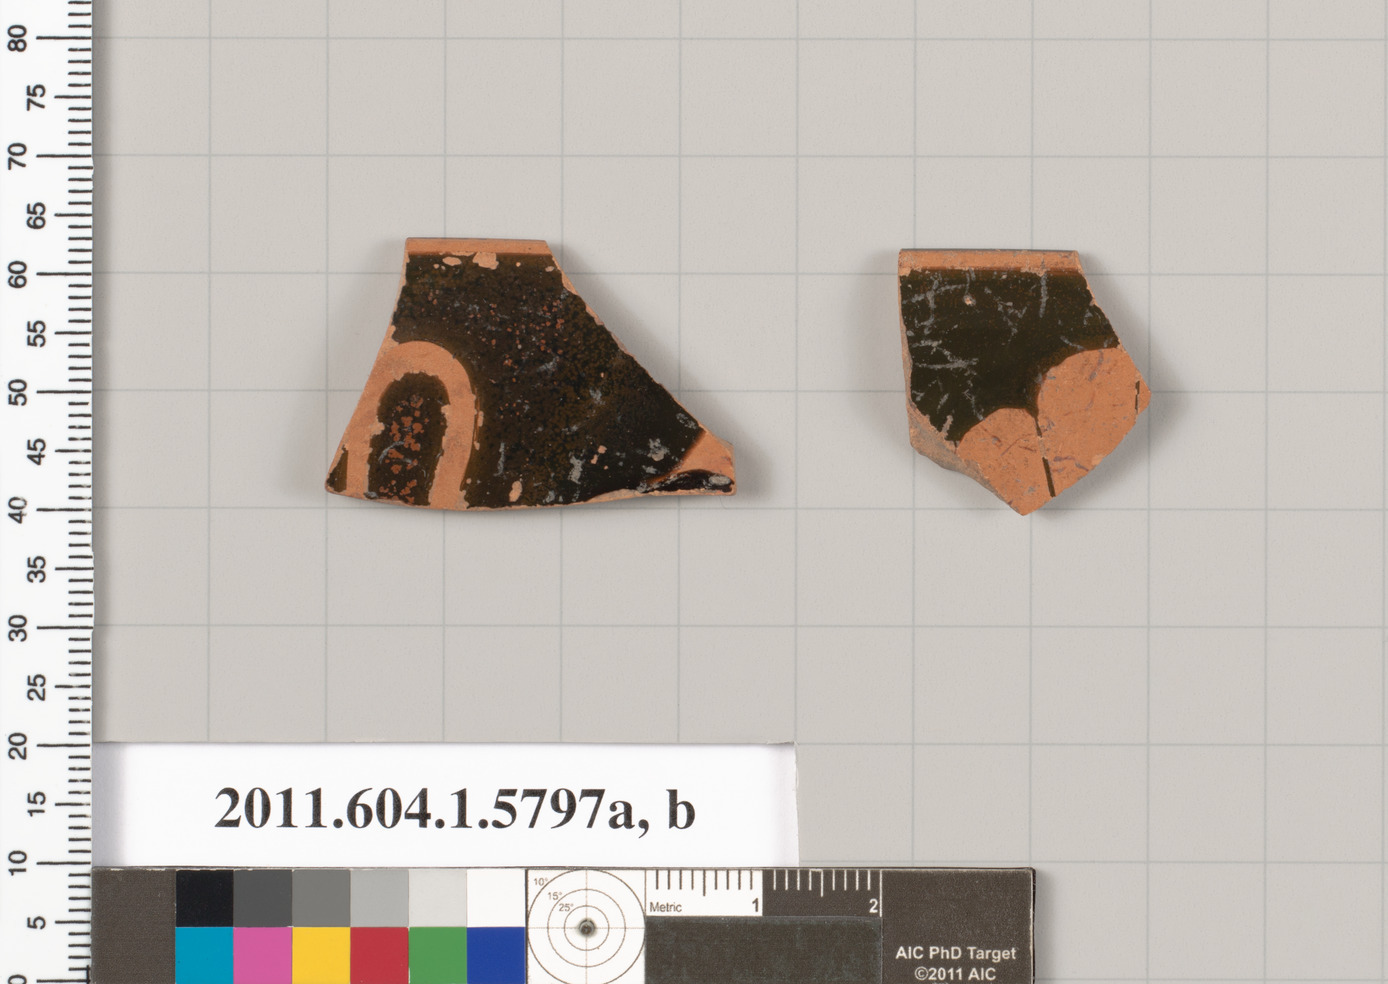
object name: kylix fragment, eye cup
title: Terracotta rim fragments of a kylix: eye-cup (drinking cup)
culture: greek, attic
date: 520-510 BCE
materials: terracotta